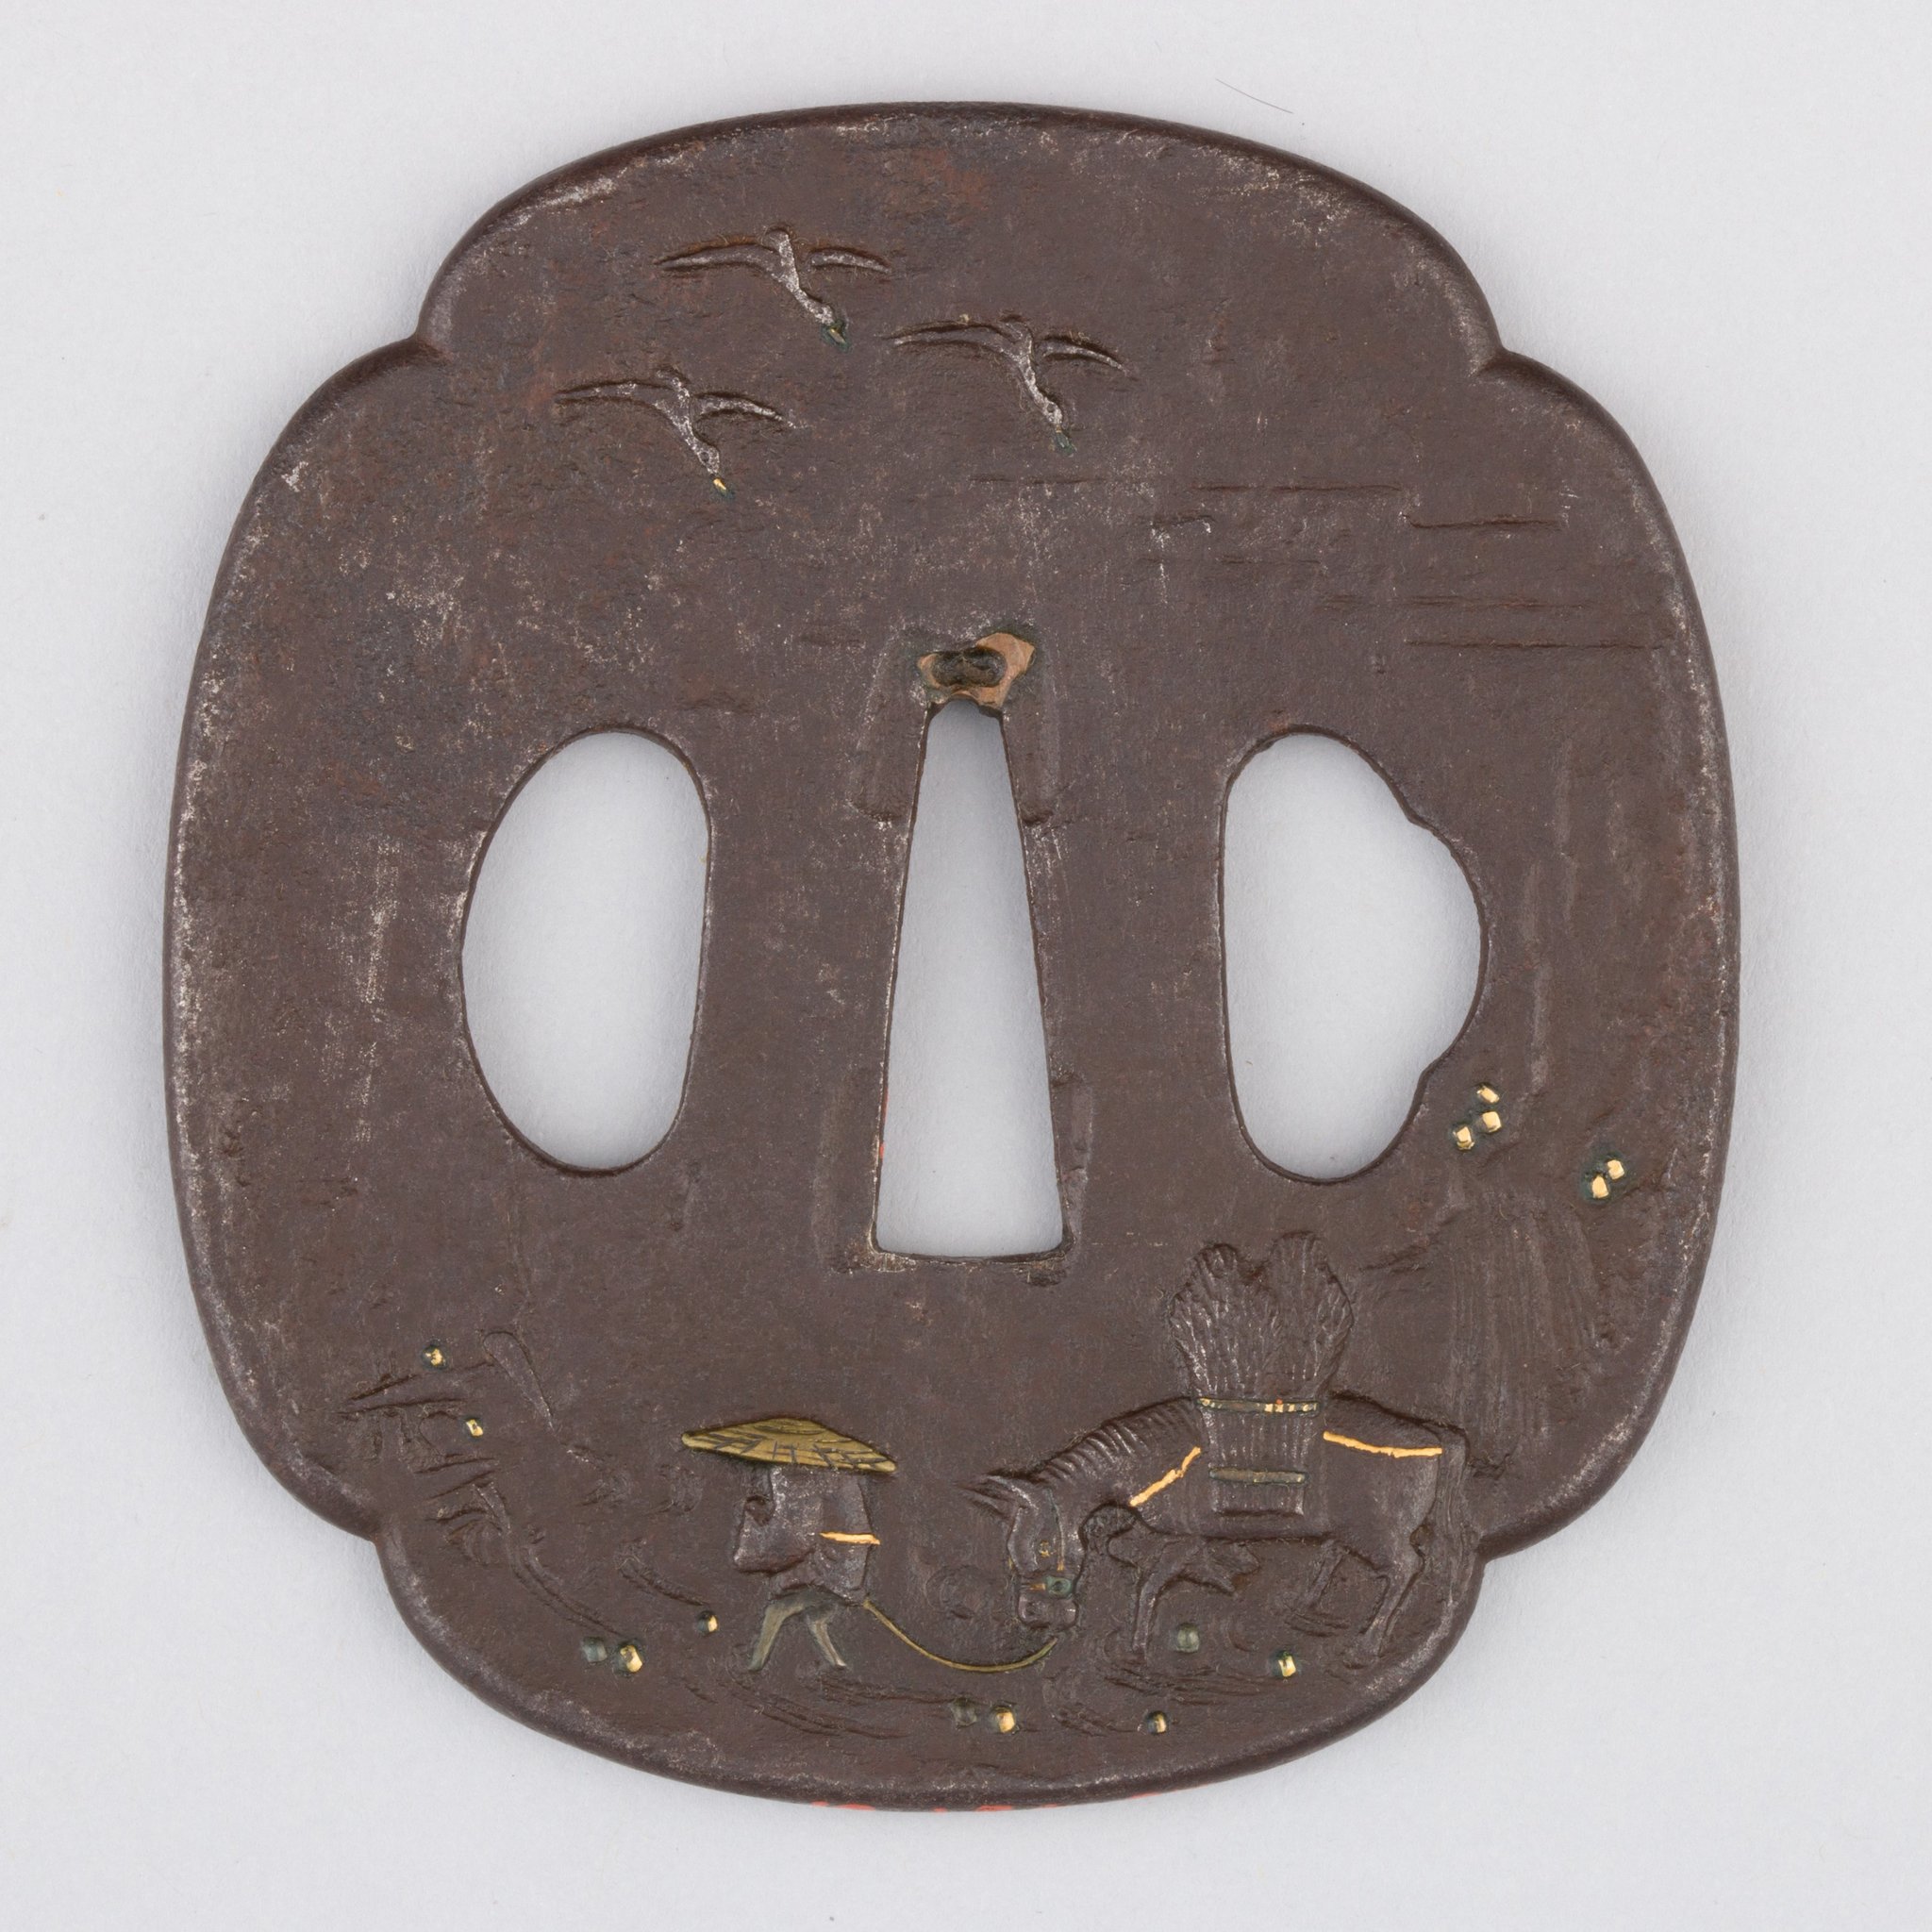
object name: sword guard tsuba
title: Sword Guard (Tsuba)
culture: japanese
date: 1615-1868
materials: copper, iron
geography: japan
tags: birds,men,horses